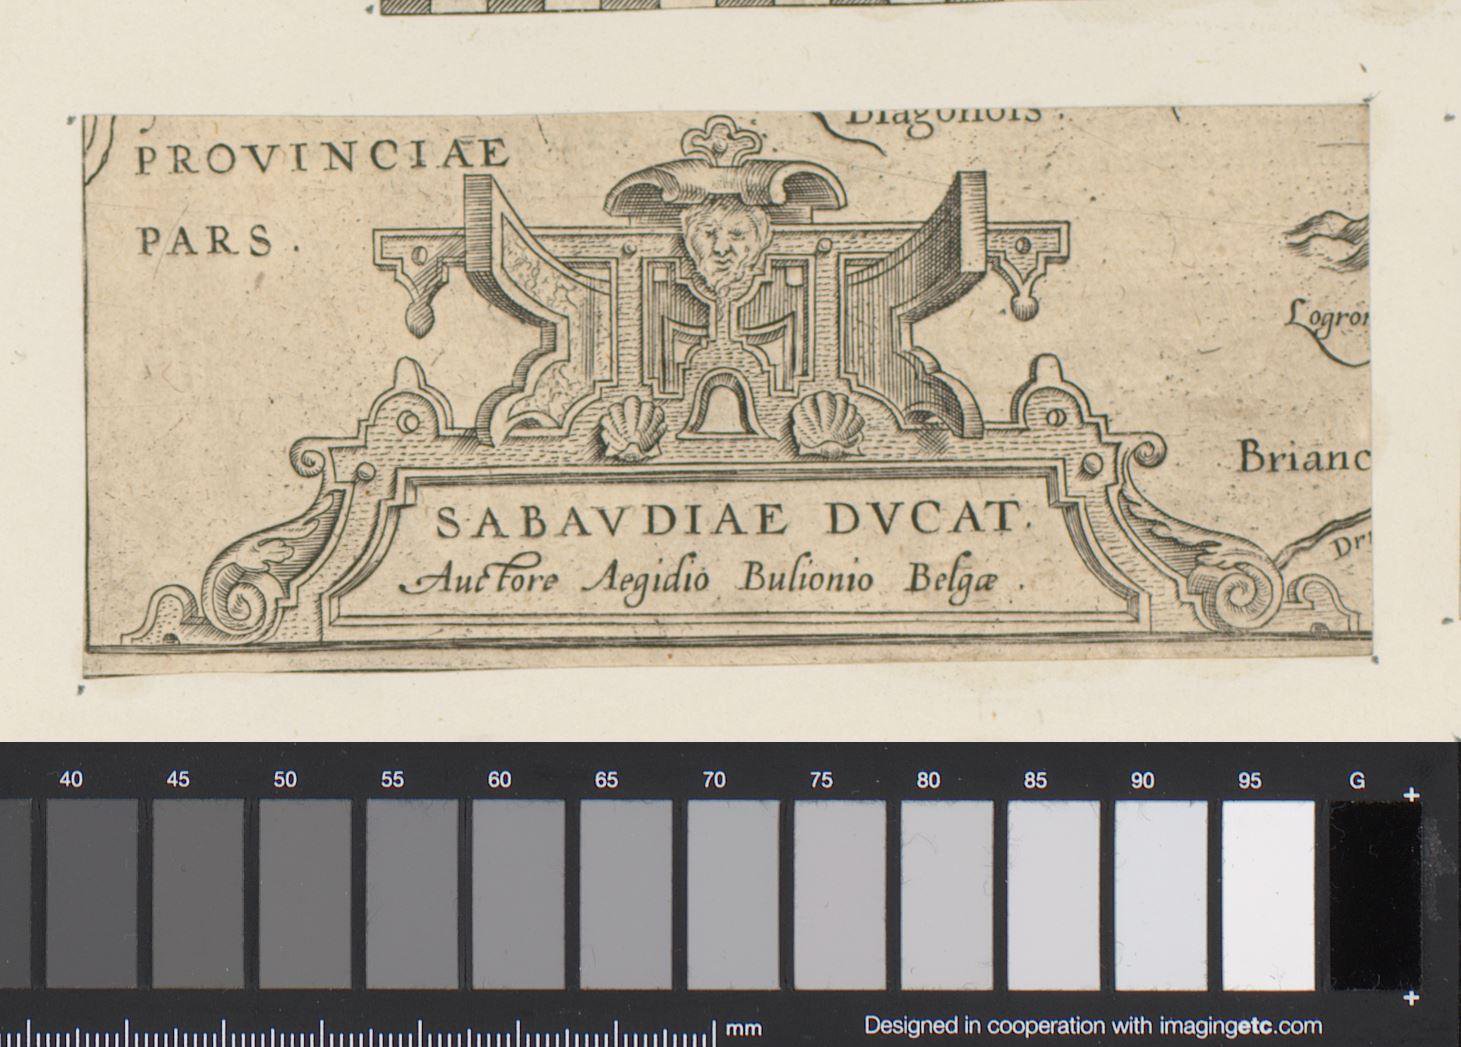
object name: album leaf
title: Theatrum Orbis Terrarum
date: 1584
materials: paper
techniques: engraving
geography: antwerp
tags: scrollwork, strapwork ~ ornament, scallop, shell ~ ornament, ornament ~ cartouche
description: Cartouche met rol- en beslagwerk en schelpornamenten. Midden boven een mascaron. De cartouche is een fragment van een kaart van Languedoc, Savoye en Venaissin. De prent maakt deel uit van een album.